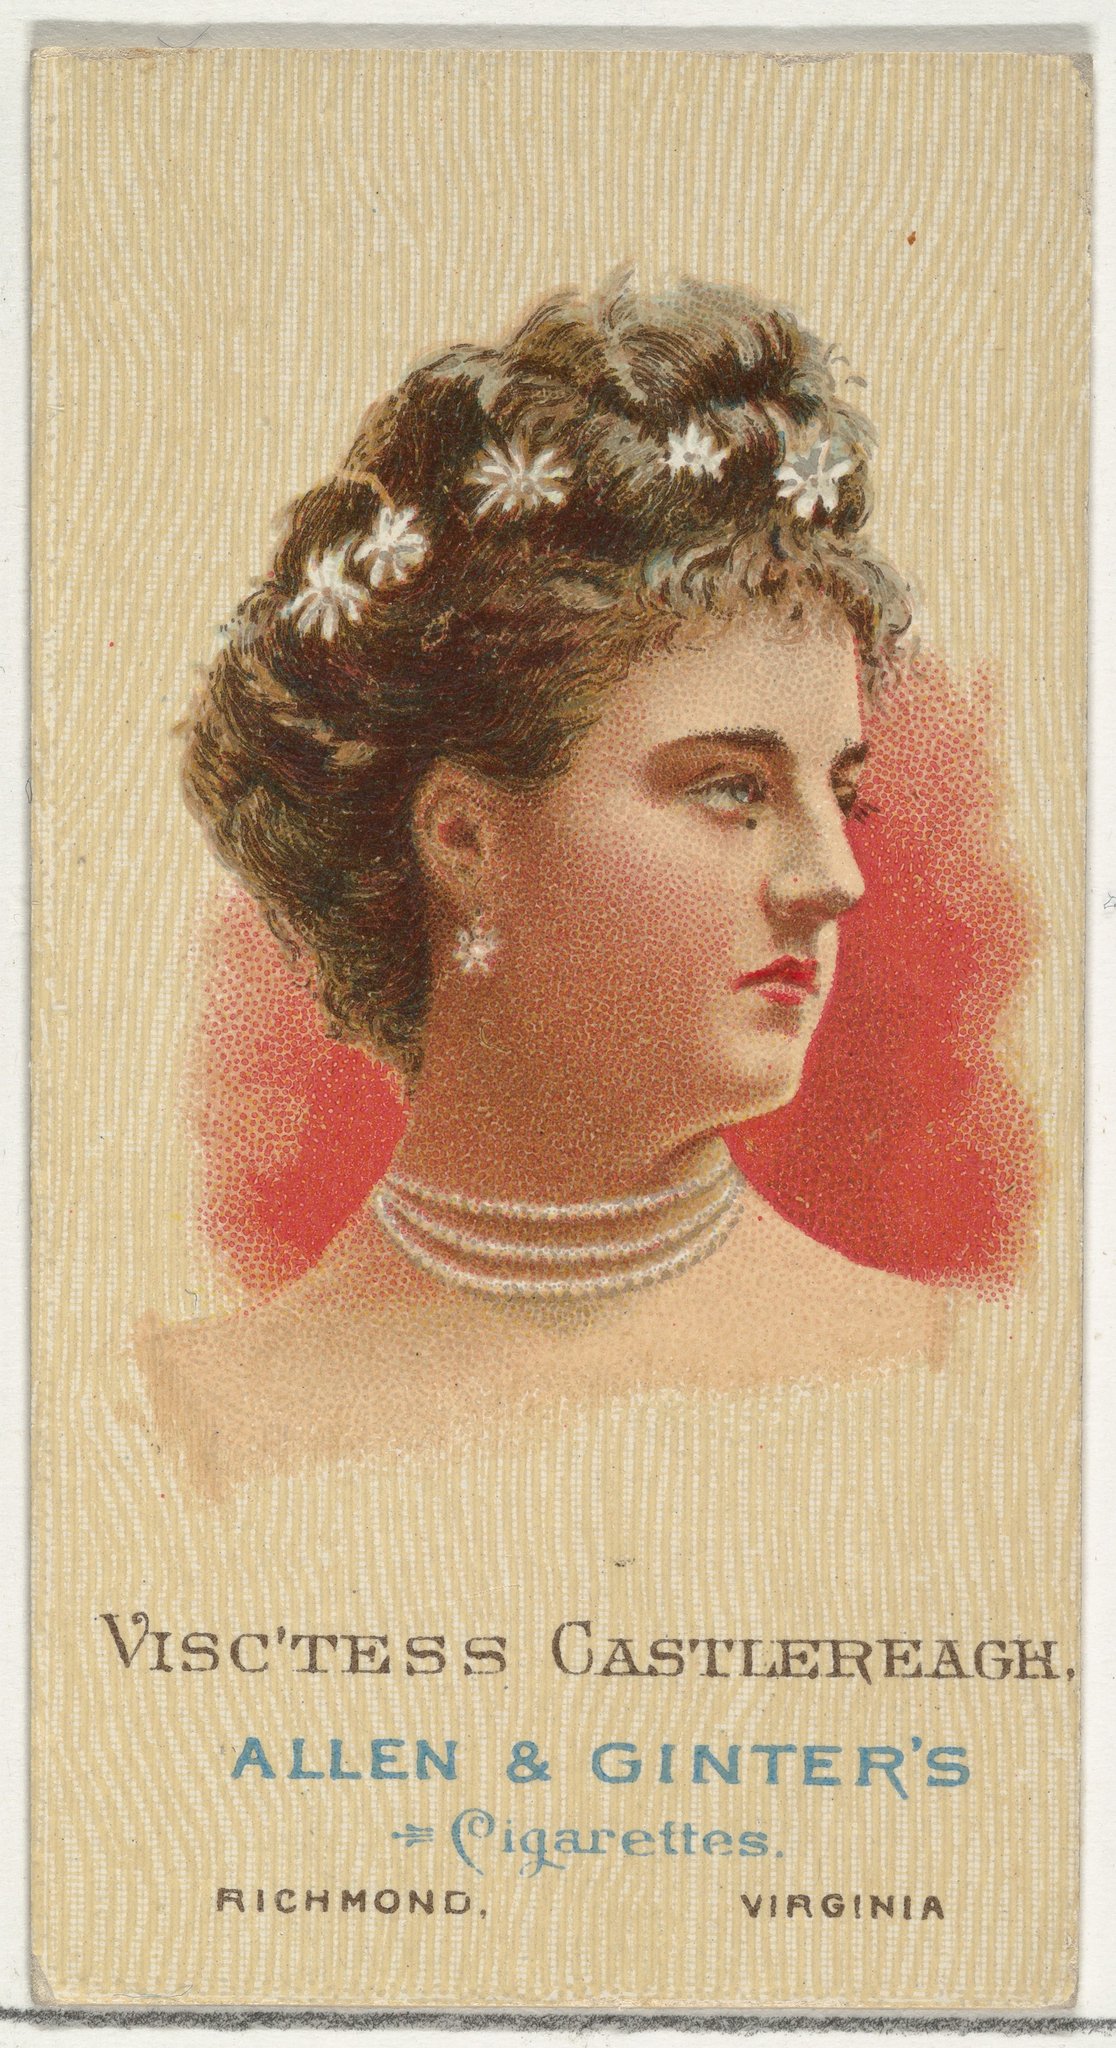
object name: print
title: Viscountess Castlereagh, from World's Beauties, Series 2 (N27) for Allen & Ginter Cigarettes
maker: allen & ginter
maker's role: publisher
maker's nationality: american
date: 1888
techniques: color lithograph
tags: women